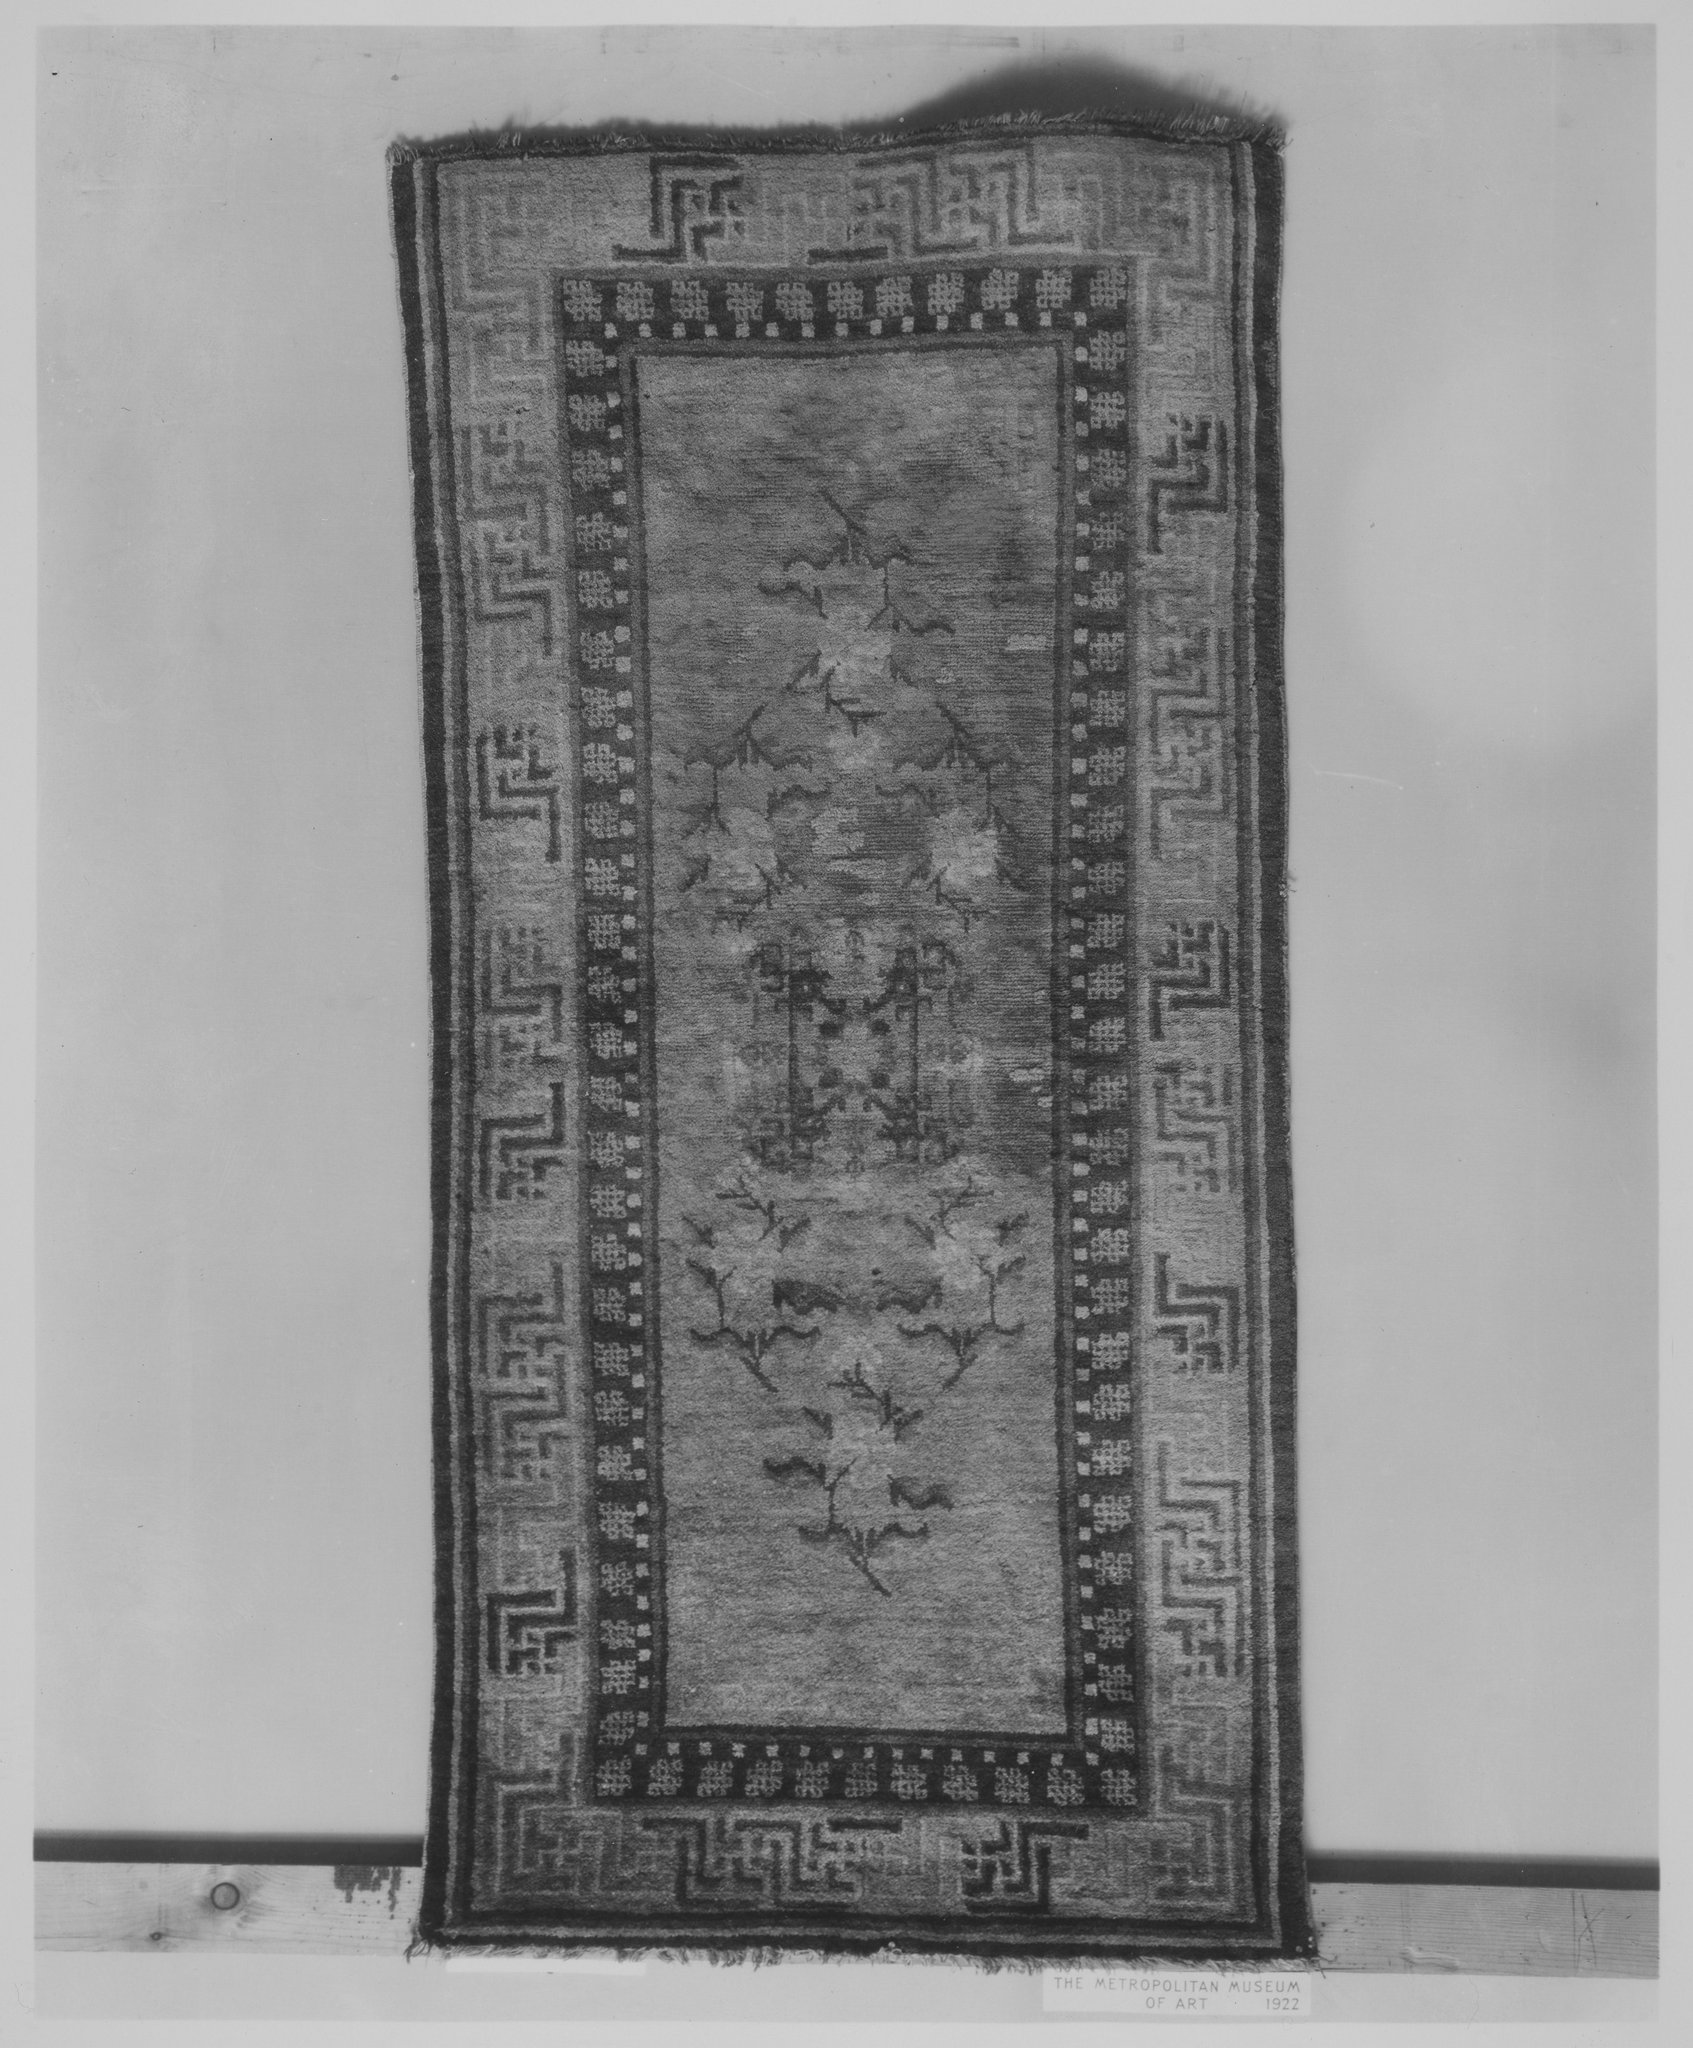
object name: rug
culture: chinese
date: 1701-1733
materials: cotton, wool